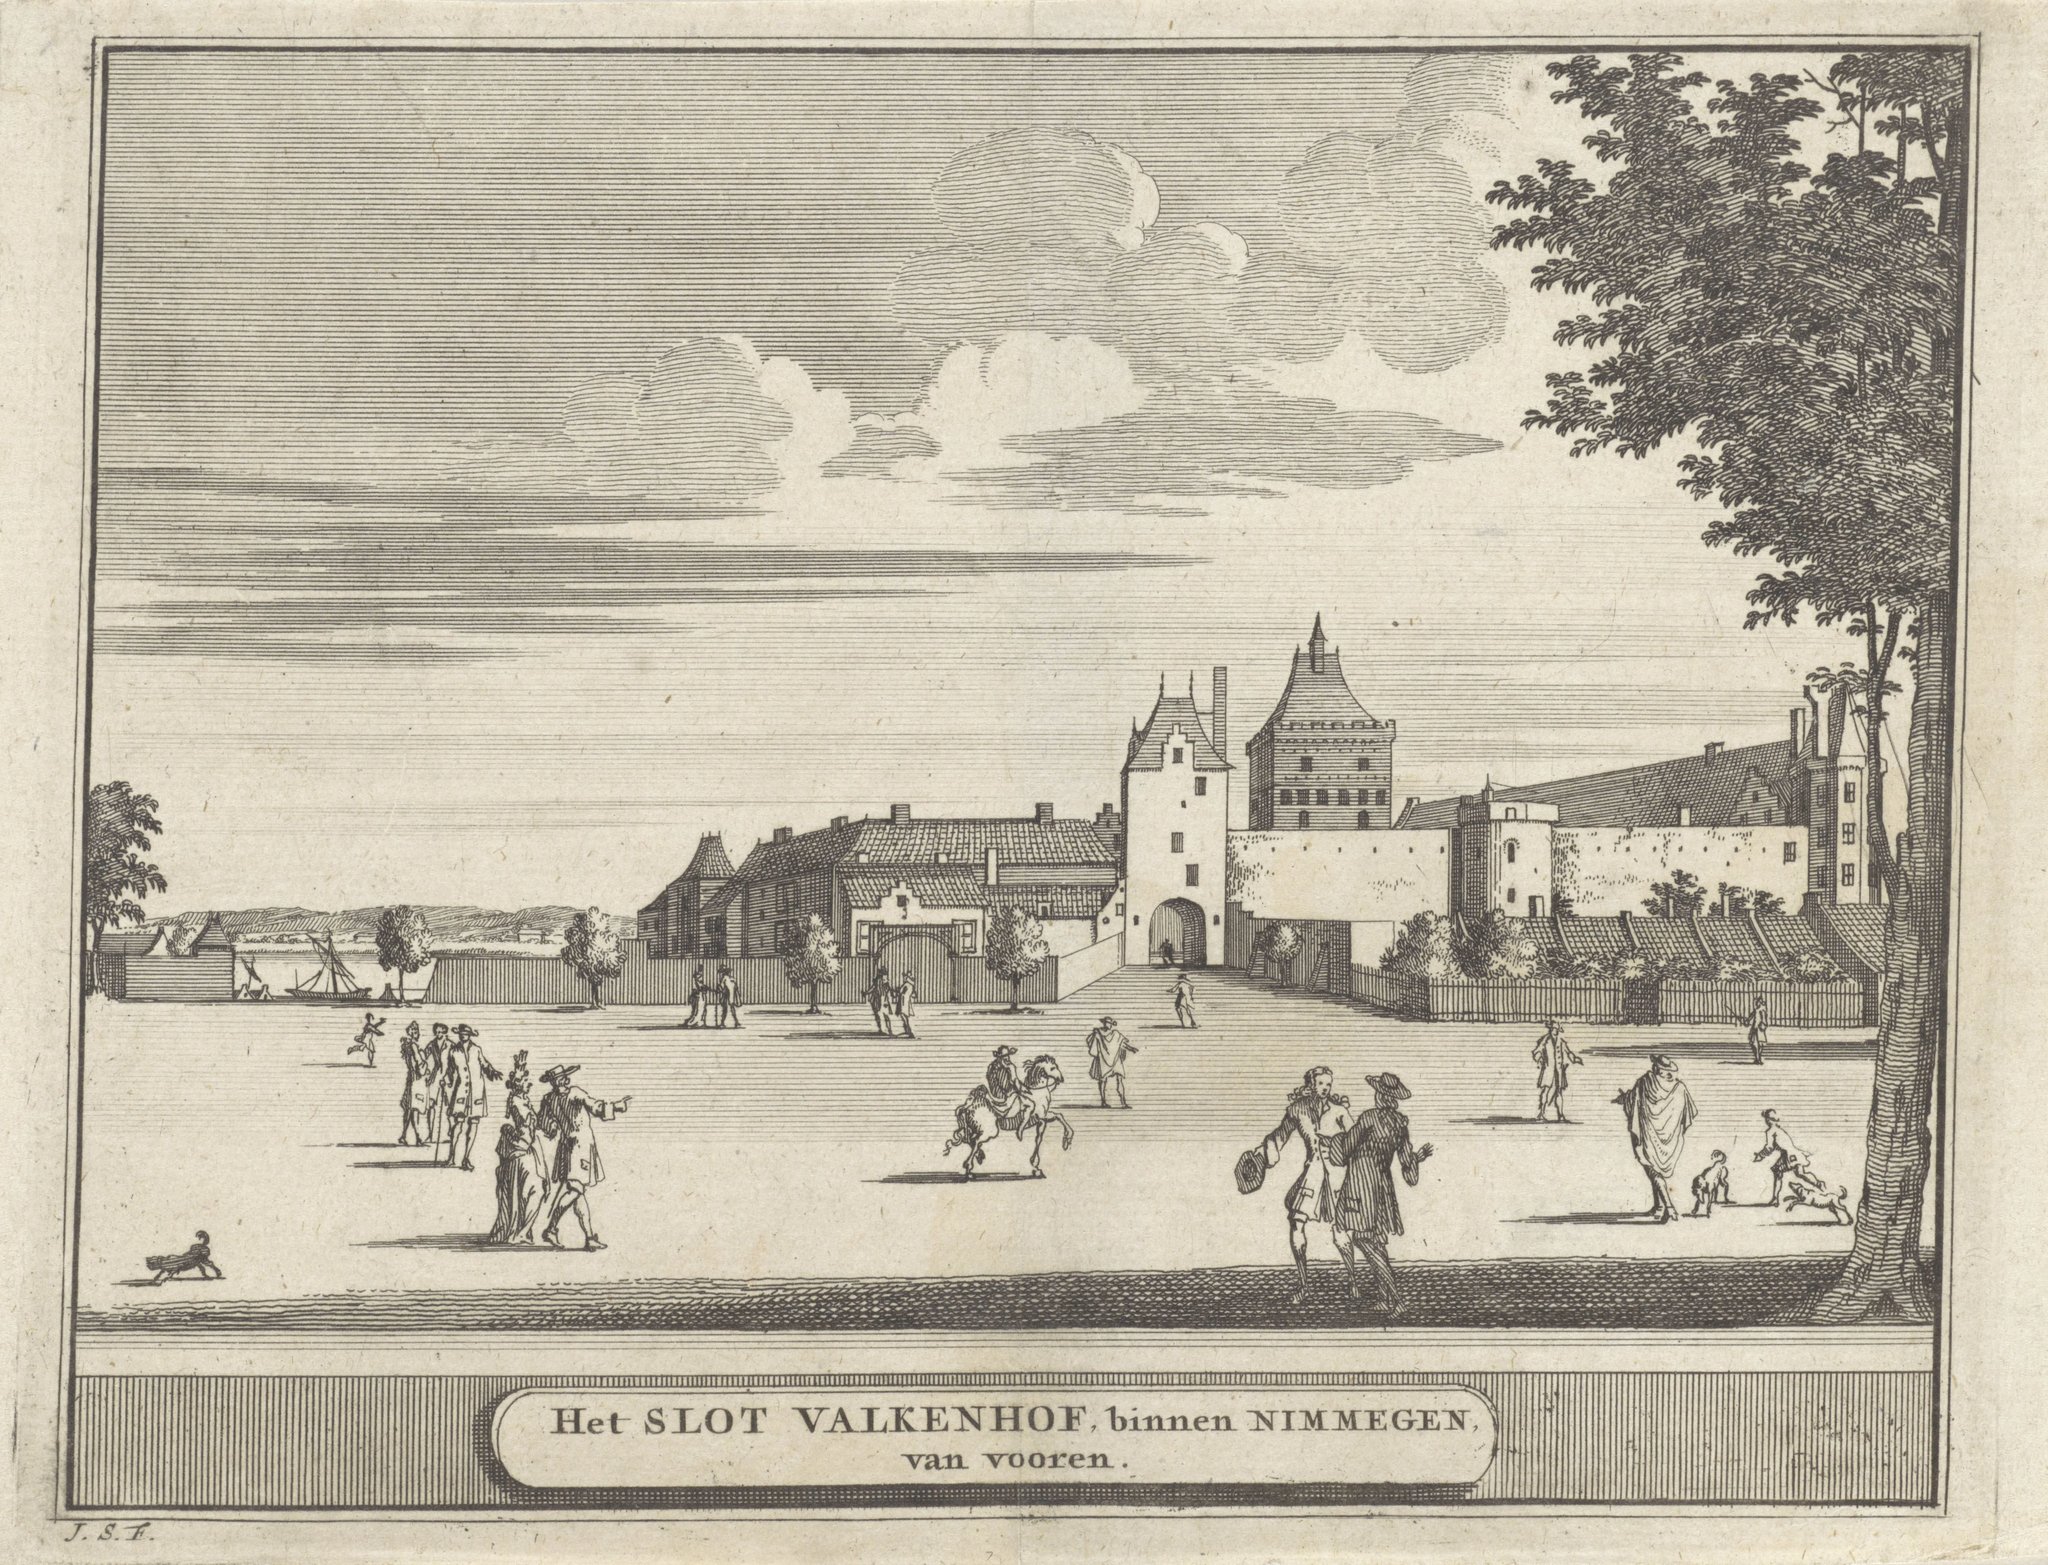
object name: print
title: Het Slot Valkenhof, binnen Nimmegen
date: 1711-1774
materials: paper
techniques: etching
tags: castle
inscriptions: collector's mark: Lugt 2228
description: Prent als illustratie opgenomen in: Smids, Ludolph. Schatkamer der Nederlandsse[!] oudheden; of Woordenboek, behelsende Nederlands steden, Amsterdam: Pieter de Coup, 1711. Verscheen tevens in de heruitgave van voorgenoemd werk in 1737 en 1774. In 1721 verscheen er een uitgave met alleen de prenten: Nederlandsche oudheden, bestaande in zestig verbeeldingen (...) gelegen in Holland, 't Sticht van Utrecht en Gelderland enz. Amsterdam: Hendrik Bosch, 1721.